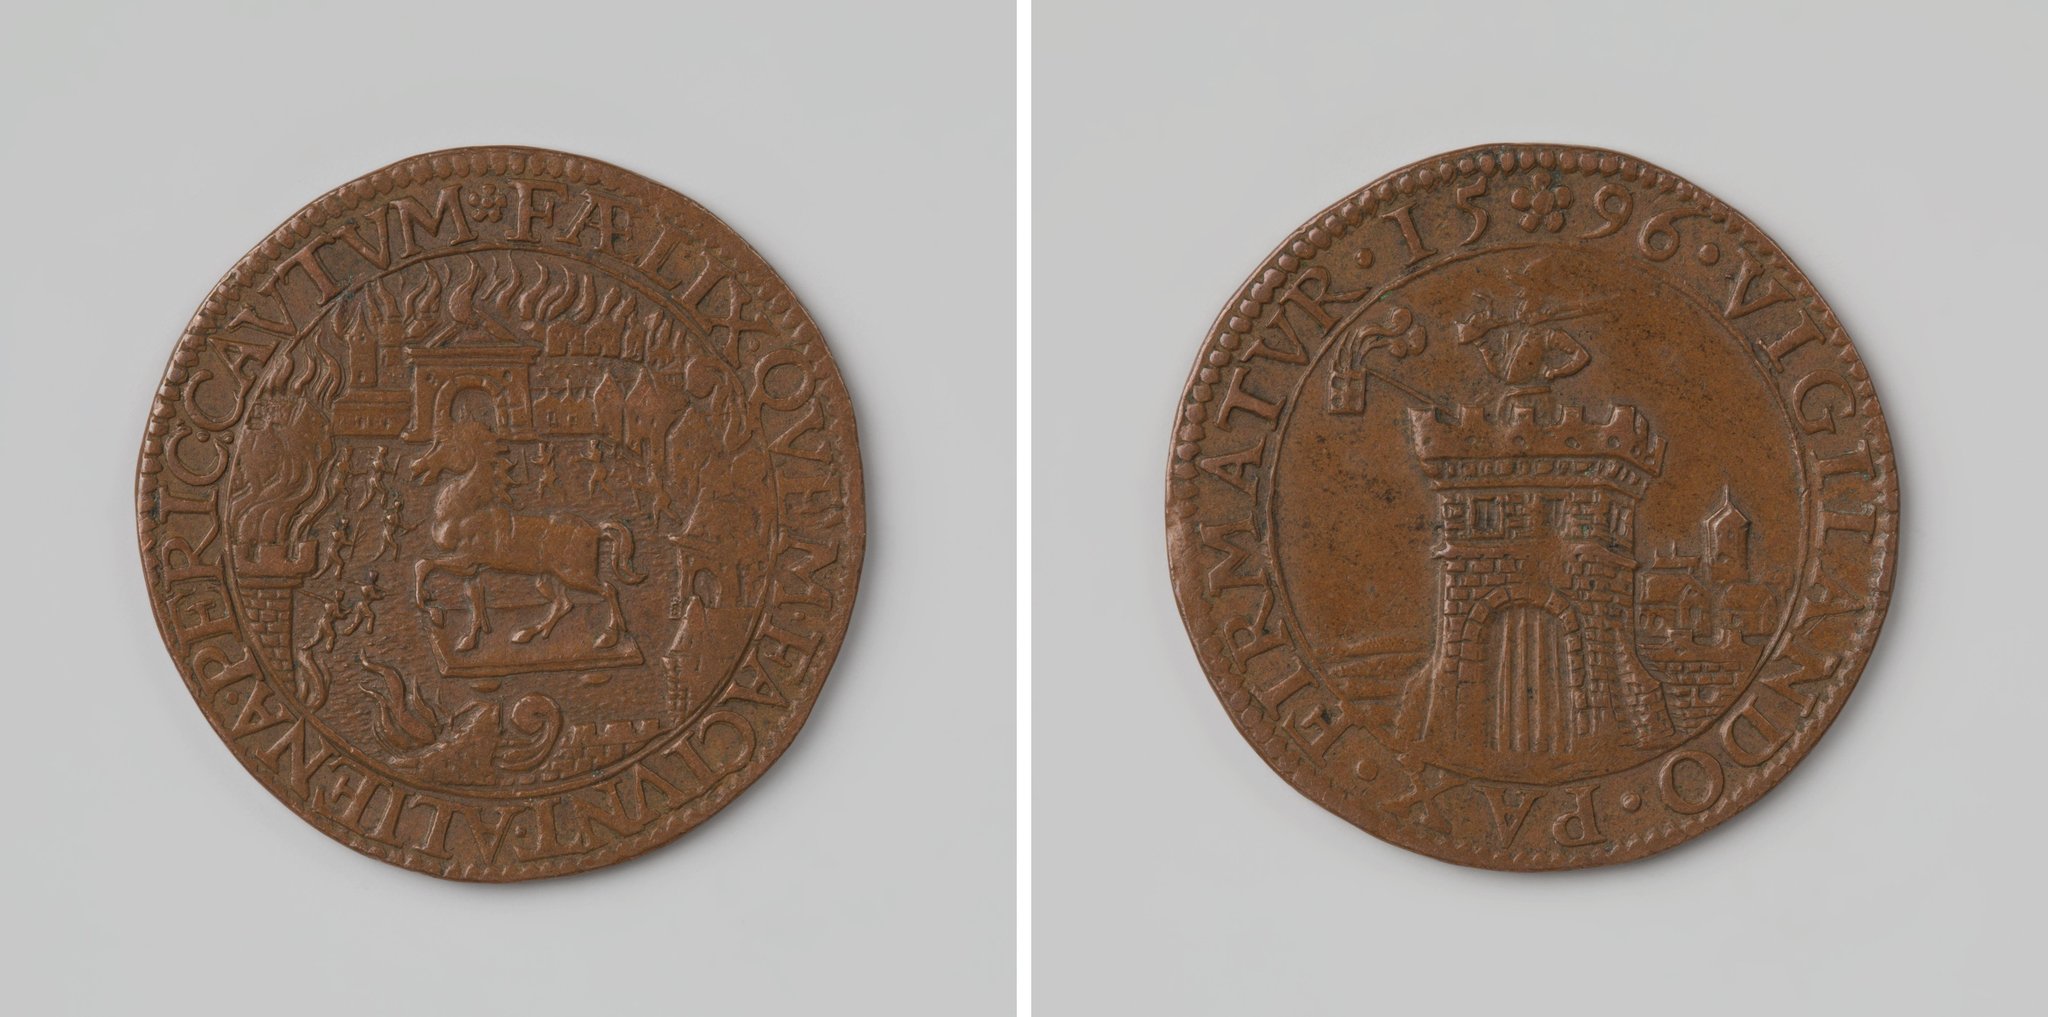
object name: jeton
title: Onbetrouwbaarheid van de Spanjaarden tijdens de vredesonderhandelingen te Middelburg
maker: Anonymous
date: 1596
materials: copper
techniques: striking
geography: dordrecht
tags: albrecht aartshertog van oostenrijk, brussels, earl, middelburg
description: Koperen penning. Voorzijde: paard van Troje, staande binnen muren van brandende stad binnen omschrift. Keerzijde: soldaat met geweer over zijn schouder, staande op toren binnen omschrift